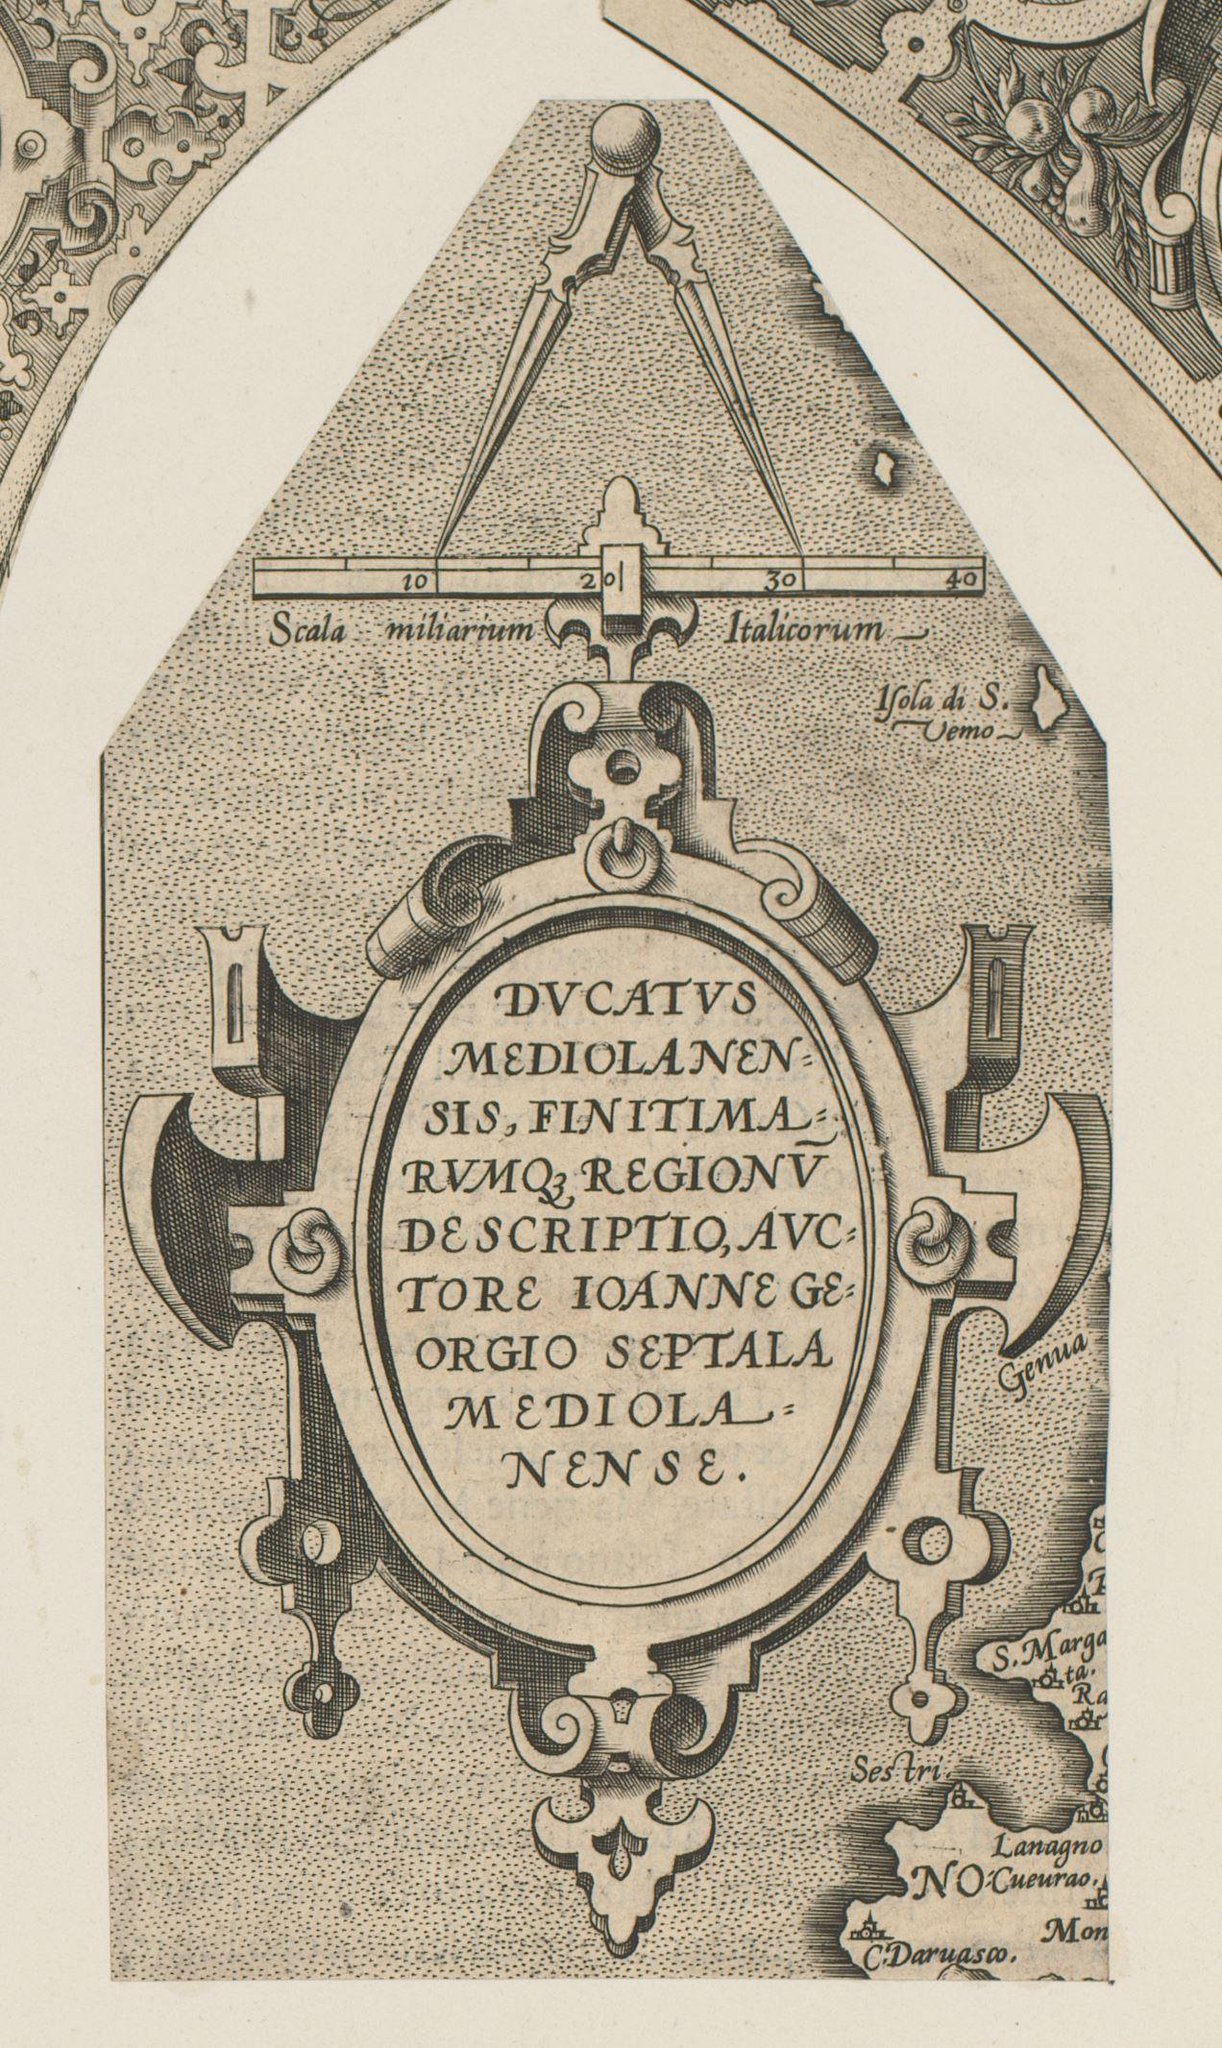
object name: album leaf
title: Theatrum Orbis Terrarum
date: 1570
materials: paper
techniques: engraving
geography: antwerp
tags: scrollwork, strapwork ~ ornament, ornament ~ cartouche, compass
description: Ovale rolwerkcartouche met bovenop een schaalstok en passer. De cartouche is een fragment van een kaart van het hertogdom Milaan. De prent maakt deel uit van een album.